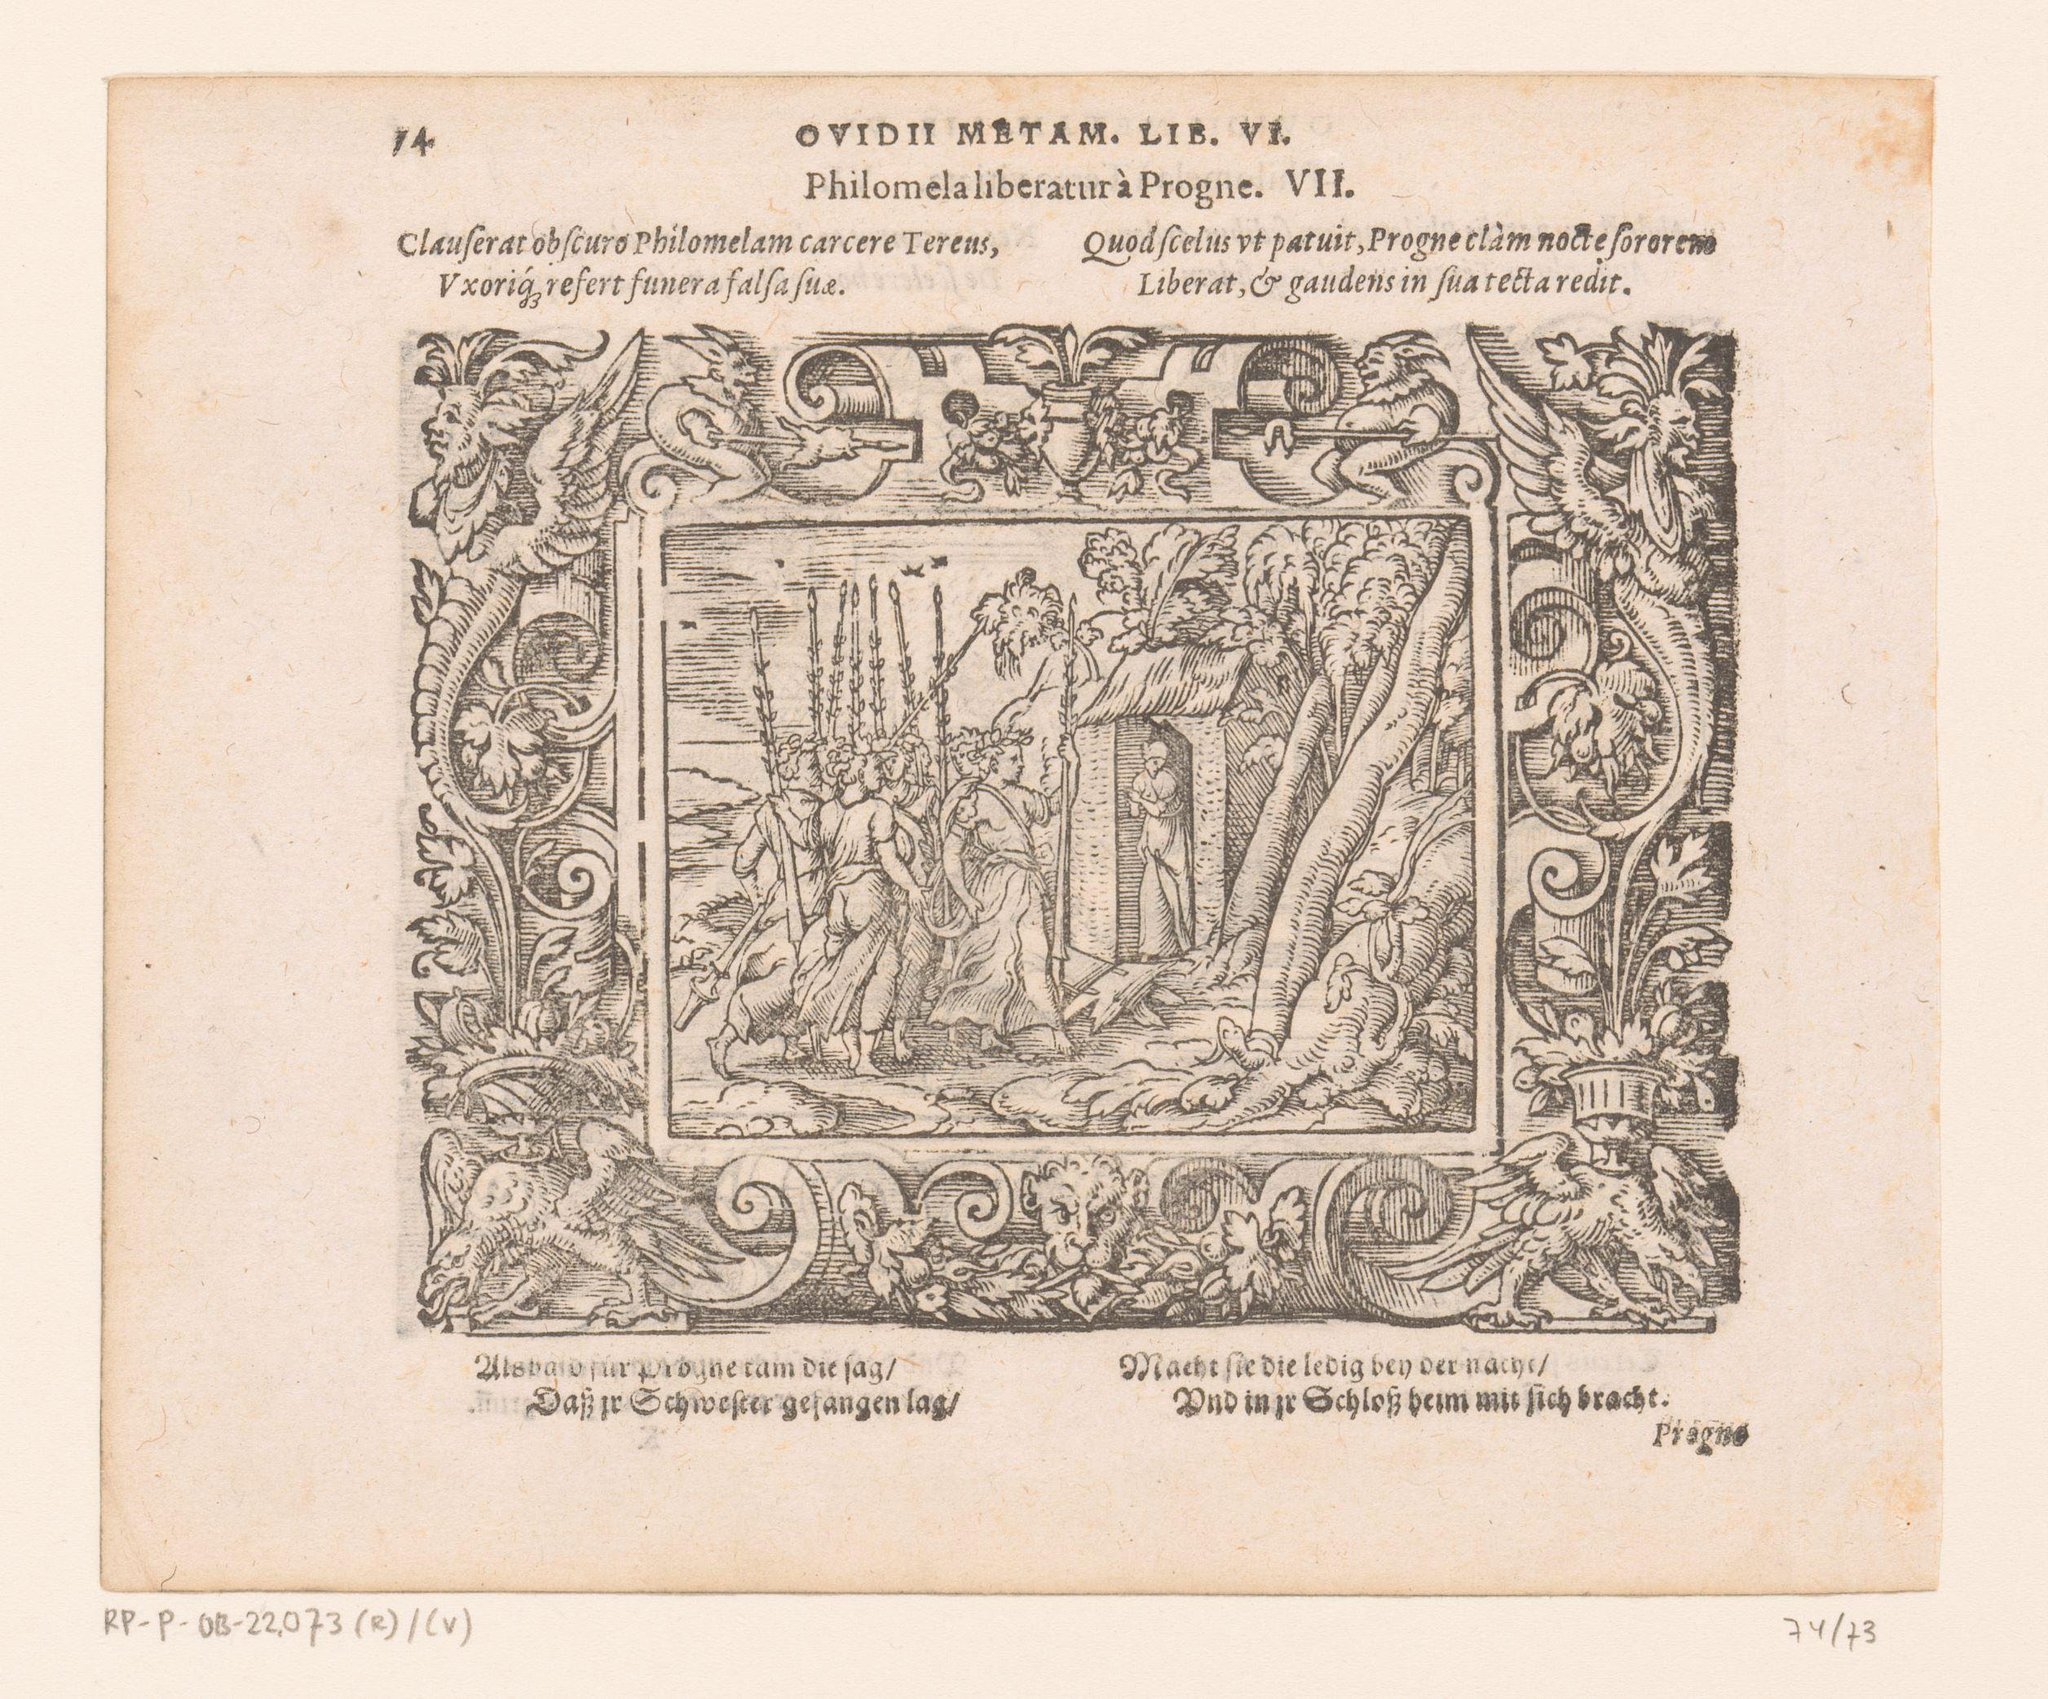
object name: book illustration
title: Procne bevrijdt Philomela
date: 1569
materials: paper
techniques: letterpress printing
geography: nuremberg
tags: during a festival of bacchus procne liberates her sister philomela, scrollwork, strapwork ~ ornament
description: Illustratie bij de Metamorfosen van Ovidius, afkomstig uit de publicatie: Posthius, Johannes. Tetrasticha in Ovidii metam. Frankfurt am Main: Georg Rab en Sigmund Feyerabend en erven Weigand Han, 1569. De voorstellingen en ornamentranden van deze boekillustraties zijn van twee aparte blokken gedrukt. Beide werden afzonderlijk van elkaar ook gebruikt voor andere publicaties, en de ornamentranden werden eveneens binnen deze publicatie meerdere keren gebruikt.